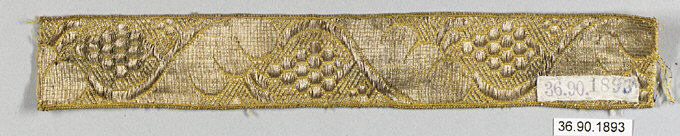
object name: galloon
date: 1767-1833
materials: metal thread, silk